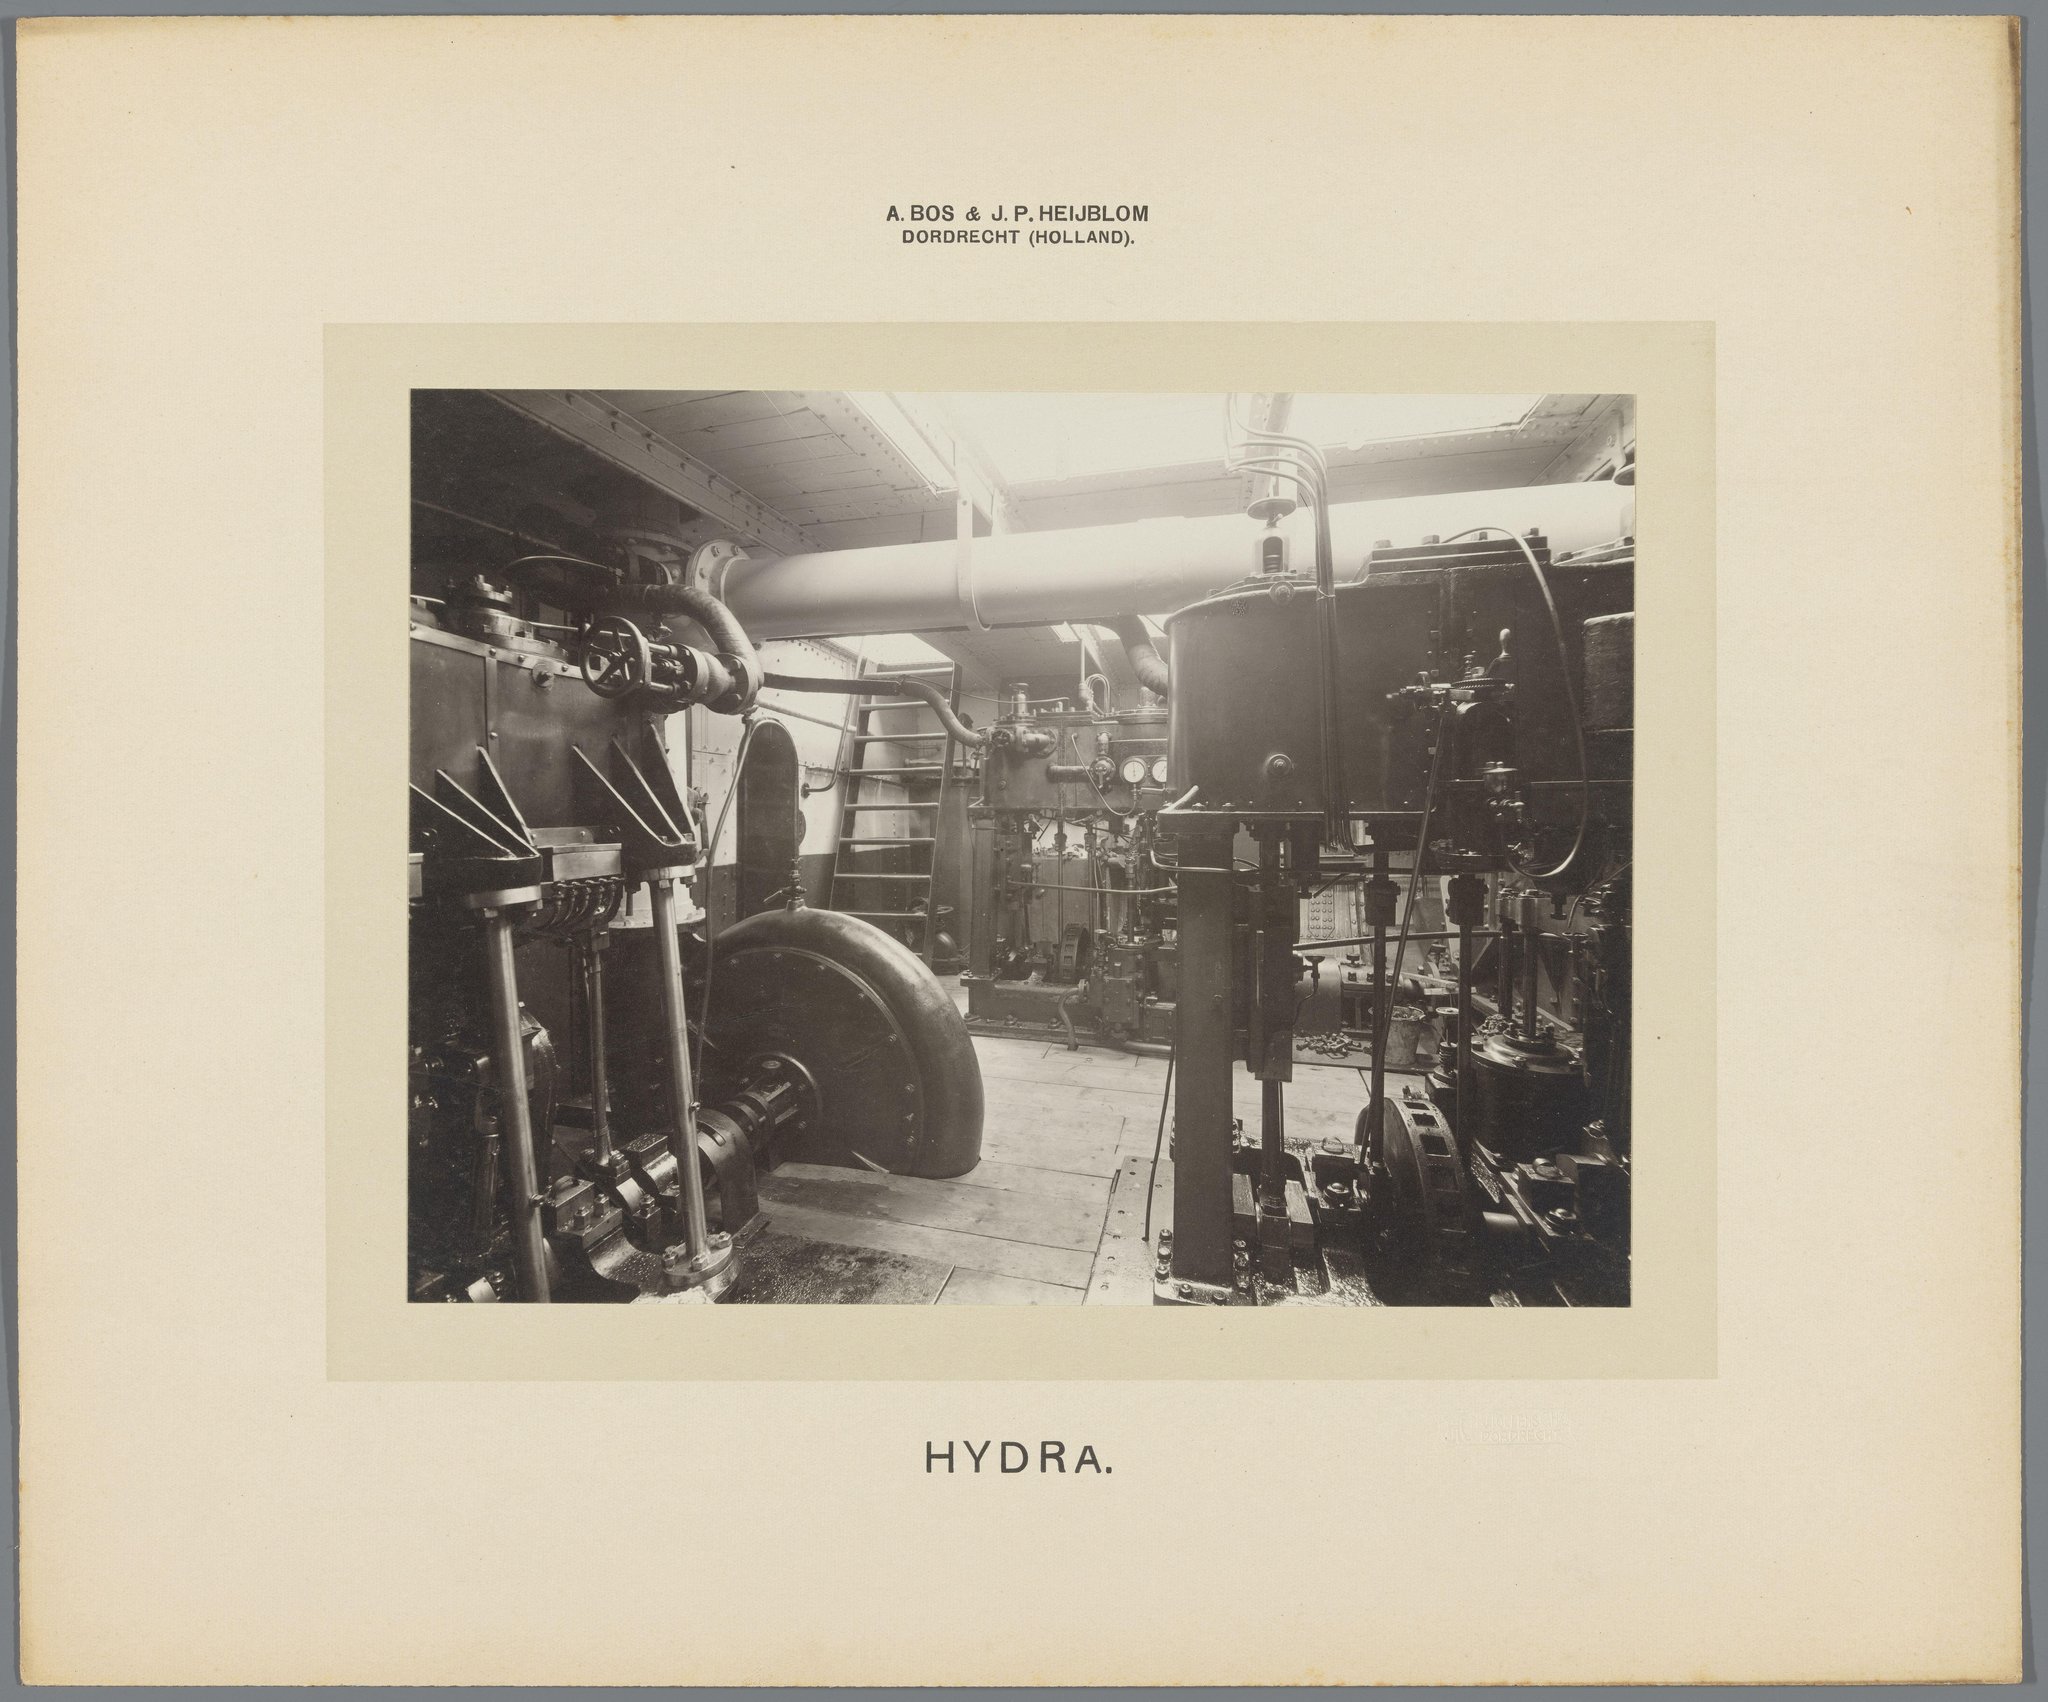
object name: photograph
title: Hydra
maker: henricus jacobus tollens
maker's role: painter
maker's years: 1864-1936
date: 1900-1910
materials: cardboard, photographic support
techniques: gelatin silver print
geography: dordrecht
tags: machine driven by steam, steamship, motorship (+ propulsion of vehicle, ship, etc. by steam), dredge, dredging machine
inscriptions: name: ‘H.J. Tollens C. Hzn. Dordrecht’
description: Machinekamer van hopperzuiger Hydra. Foto geplakt op karton. Onderdeel van de map met 44 foto's van baggerschepen van de firma A. Bos & J.P. Heijblom te Dordrecht.